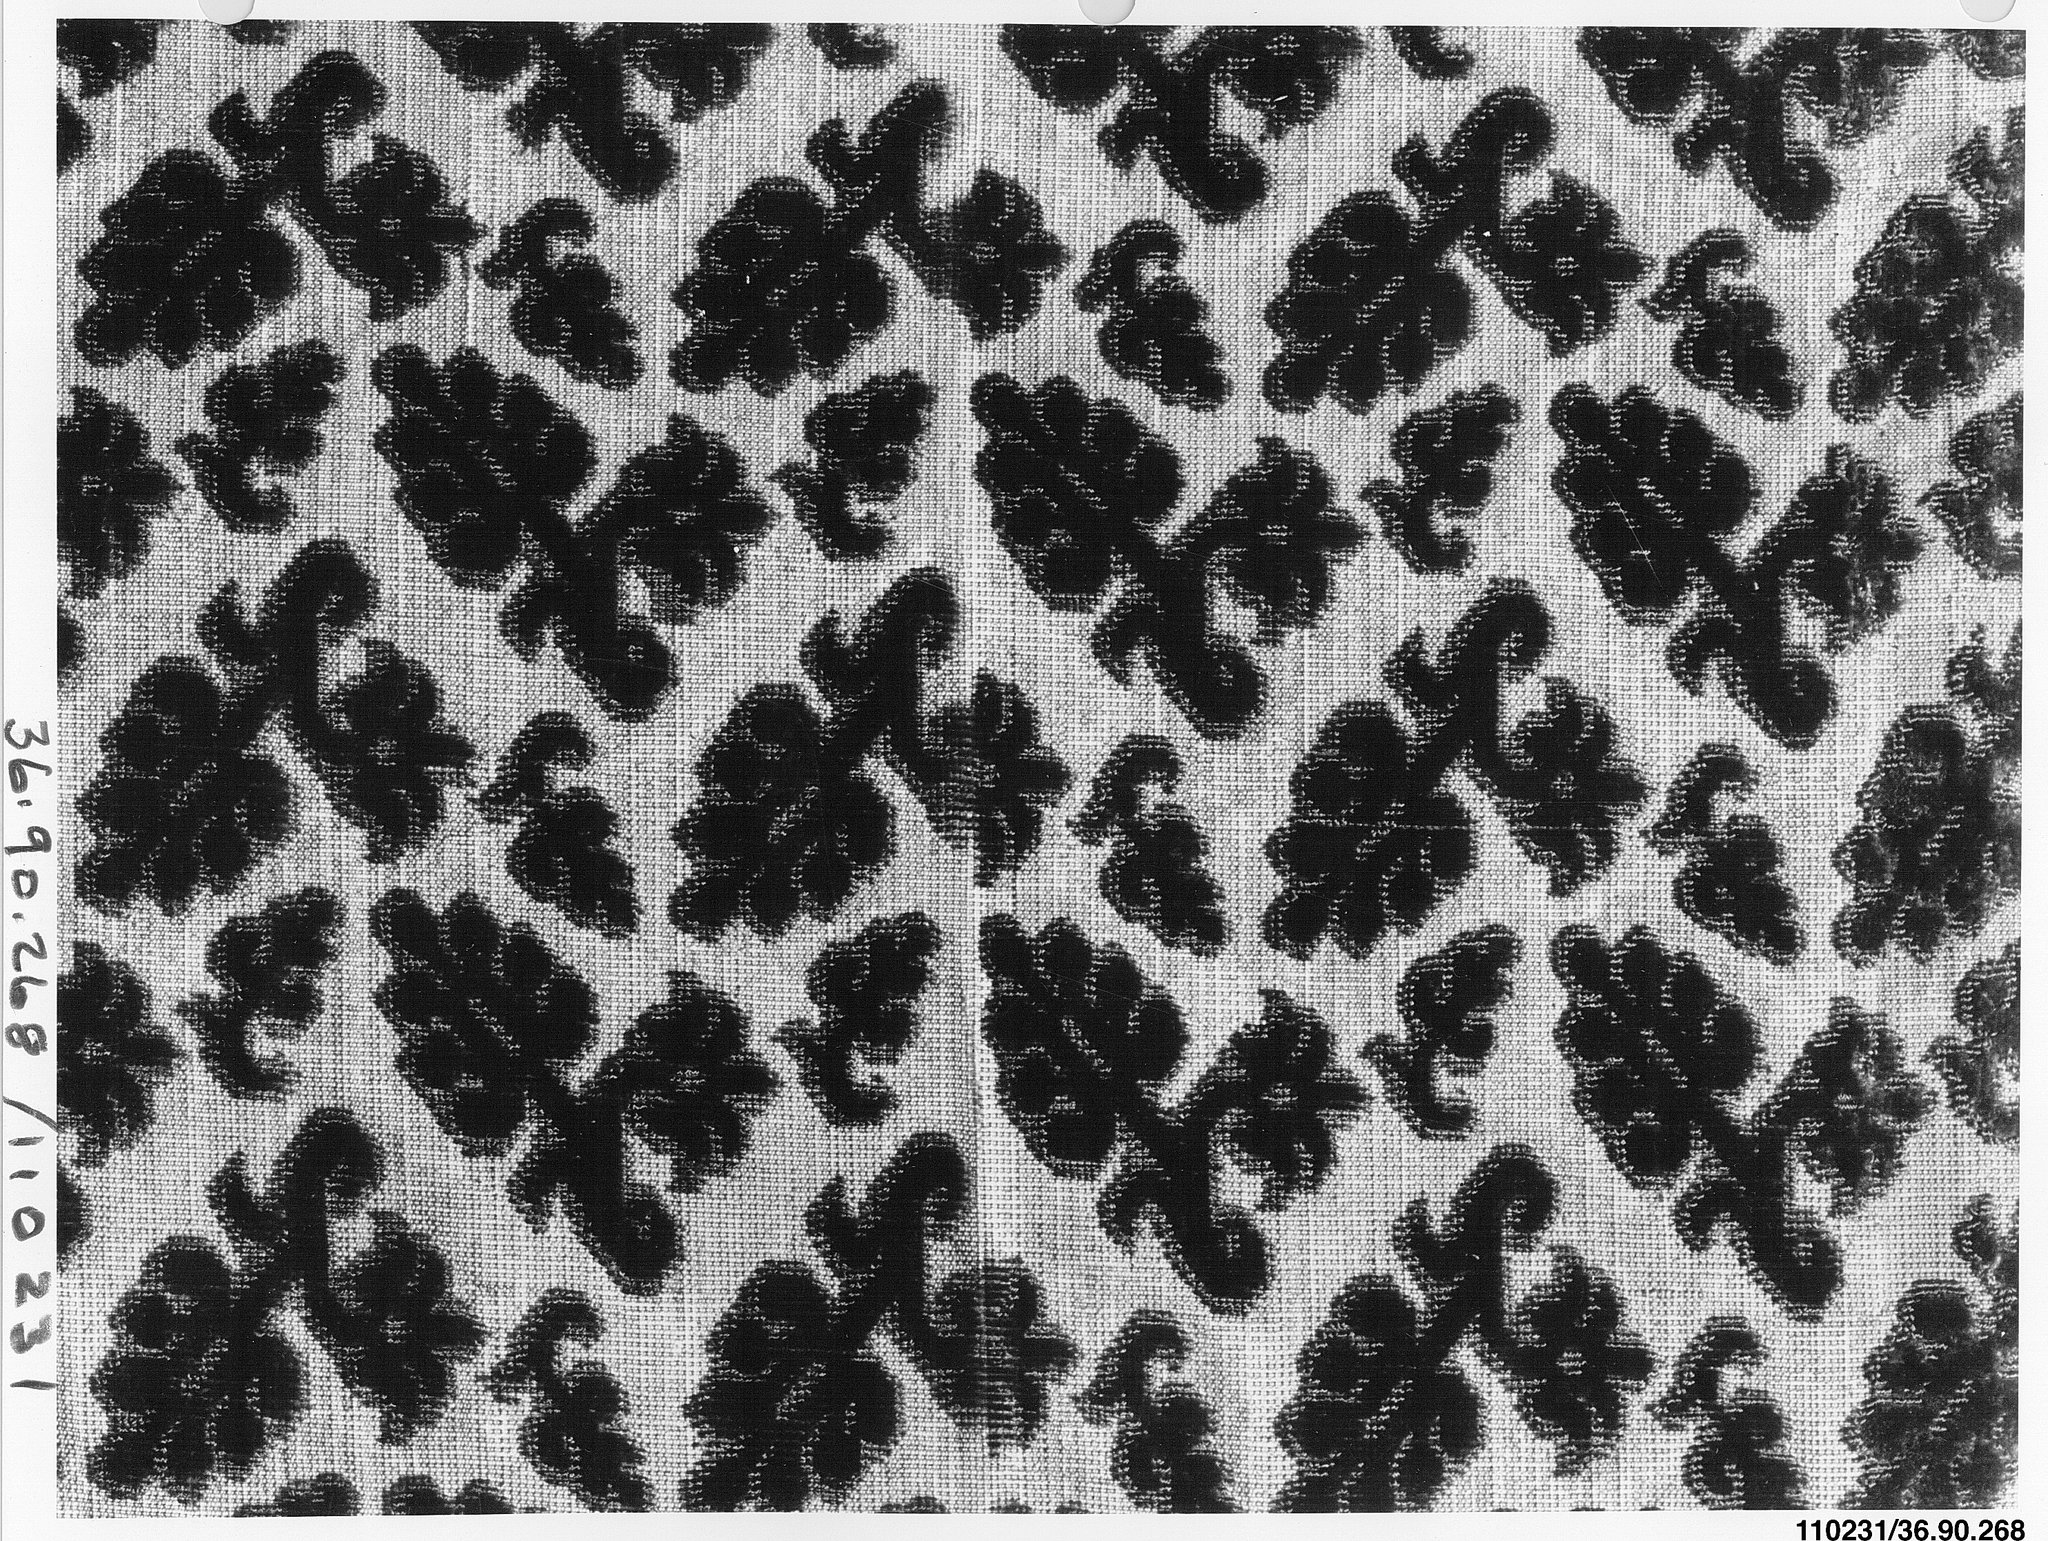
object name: piece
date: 1501-1700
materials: metal thread, silk